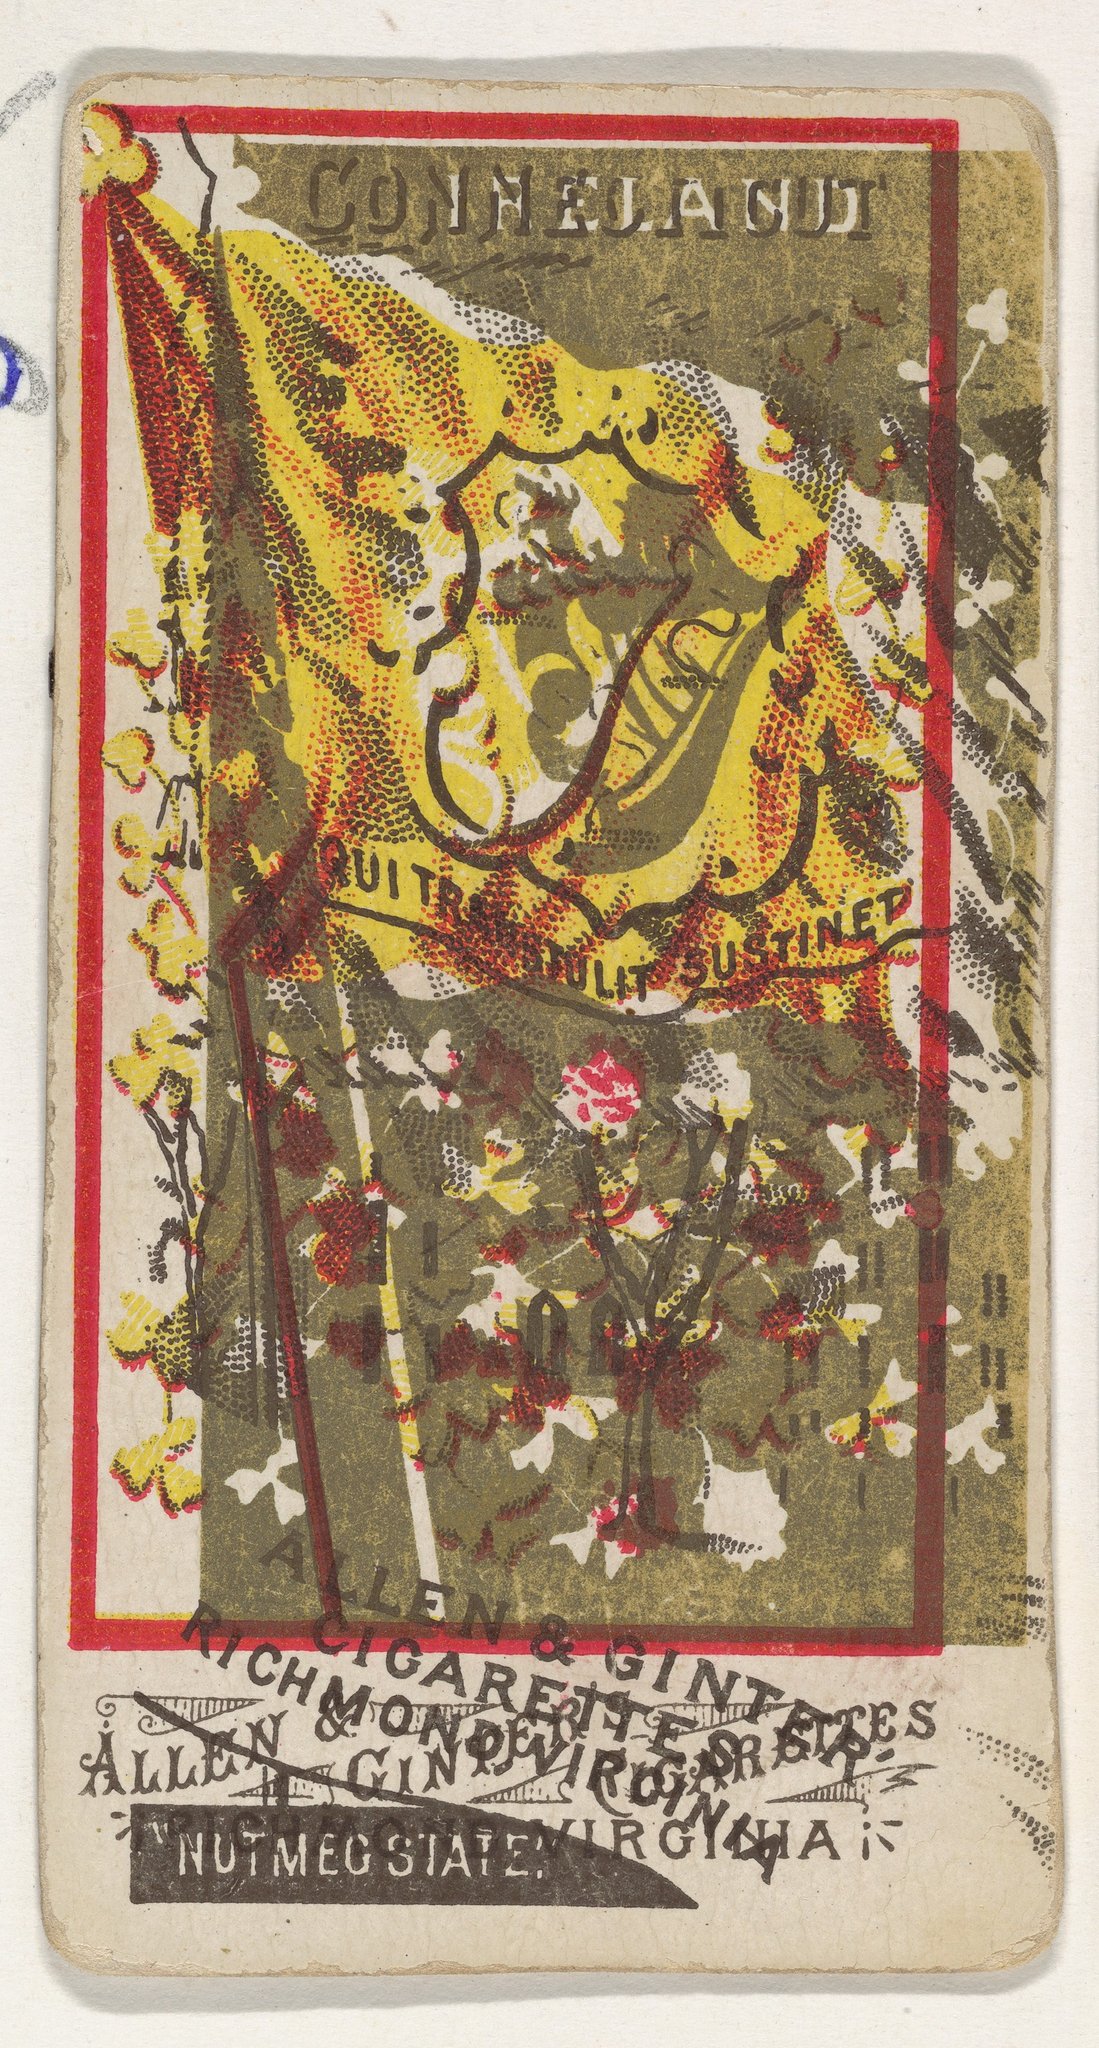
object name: print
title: Connecticut and Ireland (double-printed card), from Flags of All Nations, Series 1 (N9) for Allen & Ginter Cigarettes Brands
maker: allen & ginter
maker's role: publisher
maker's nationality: american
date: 1887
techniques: color lithograph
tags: flags